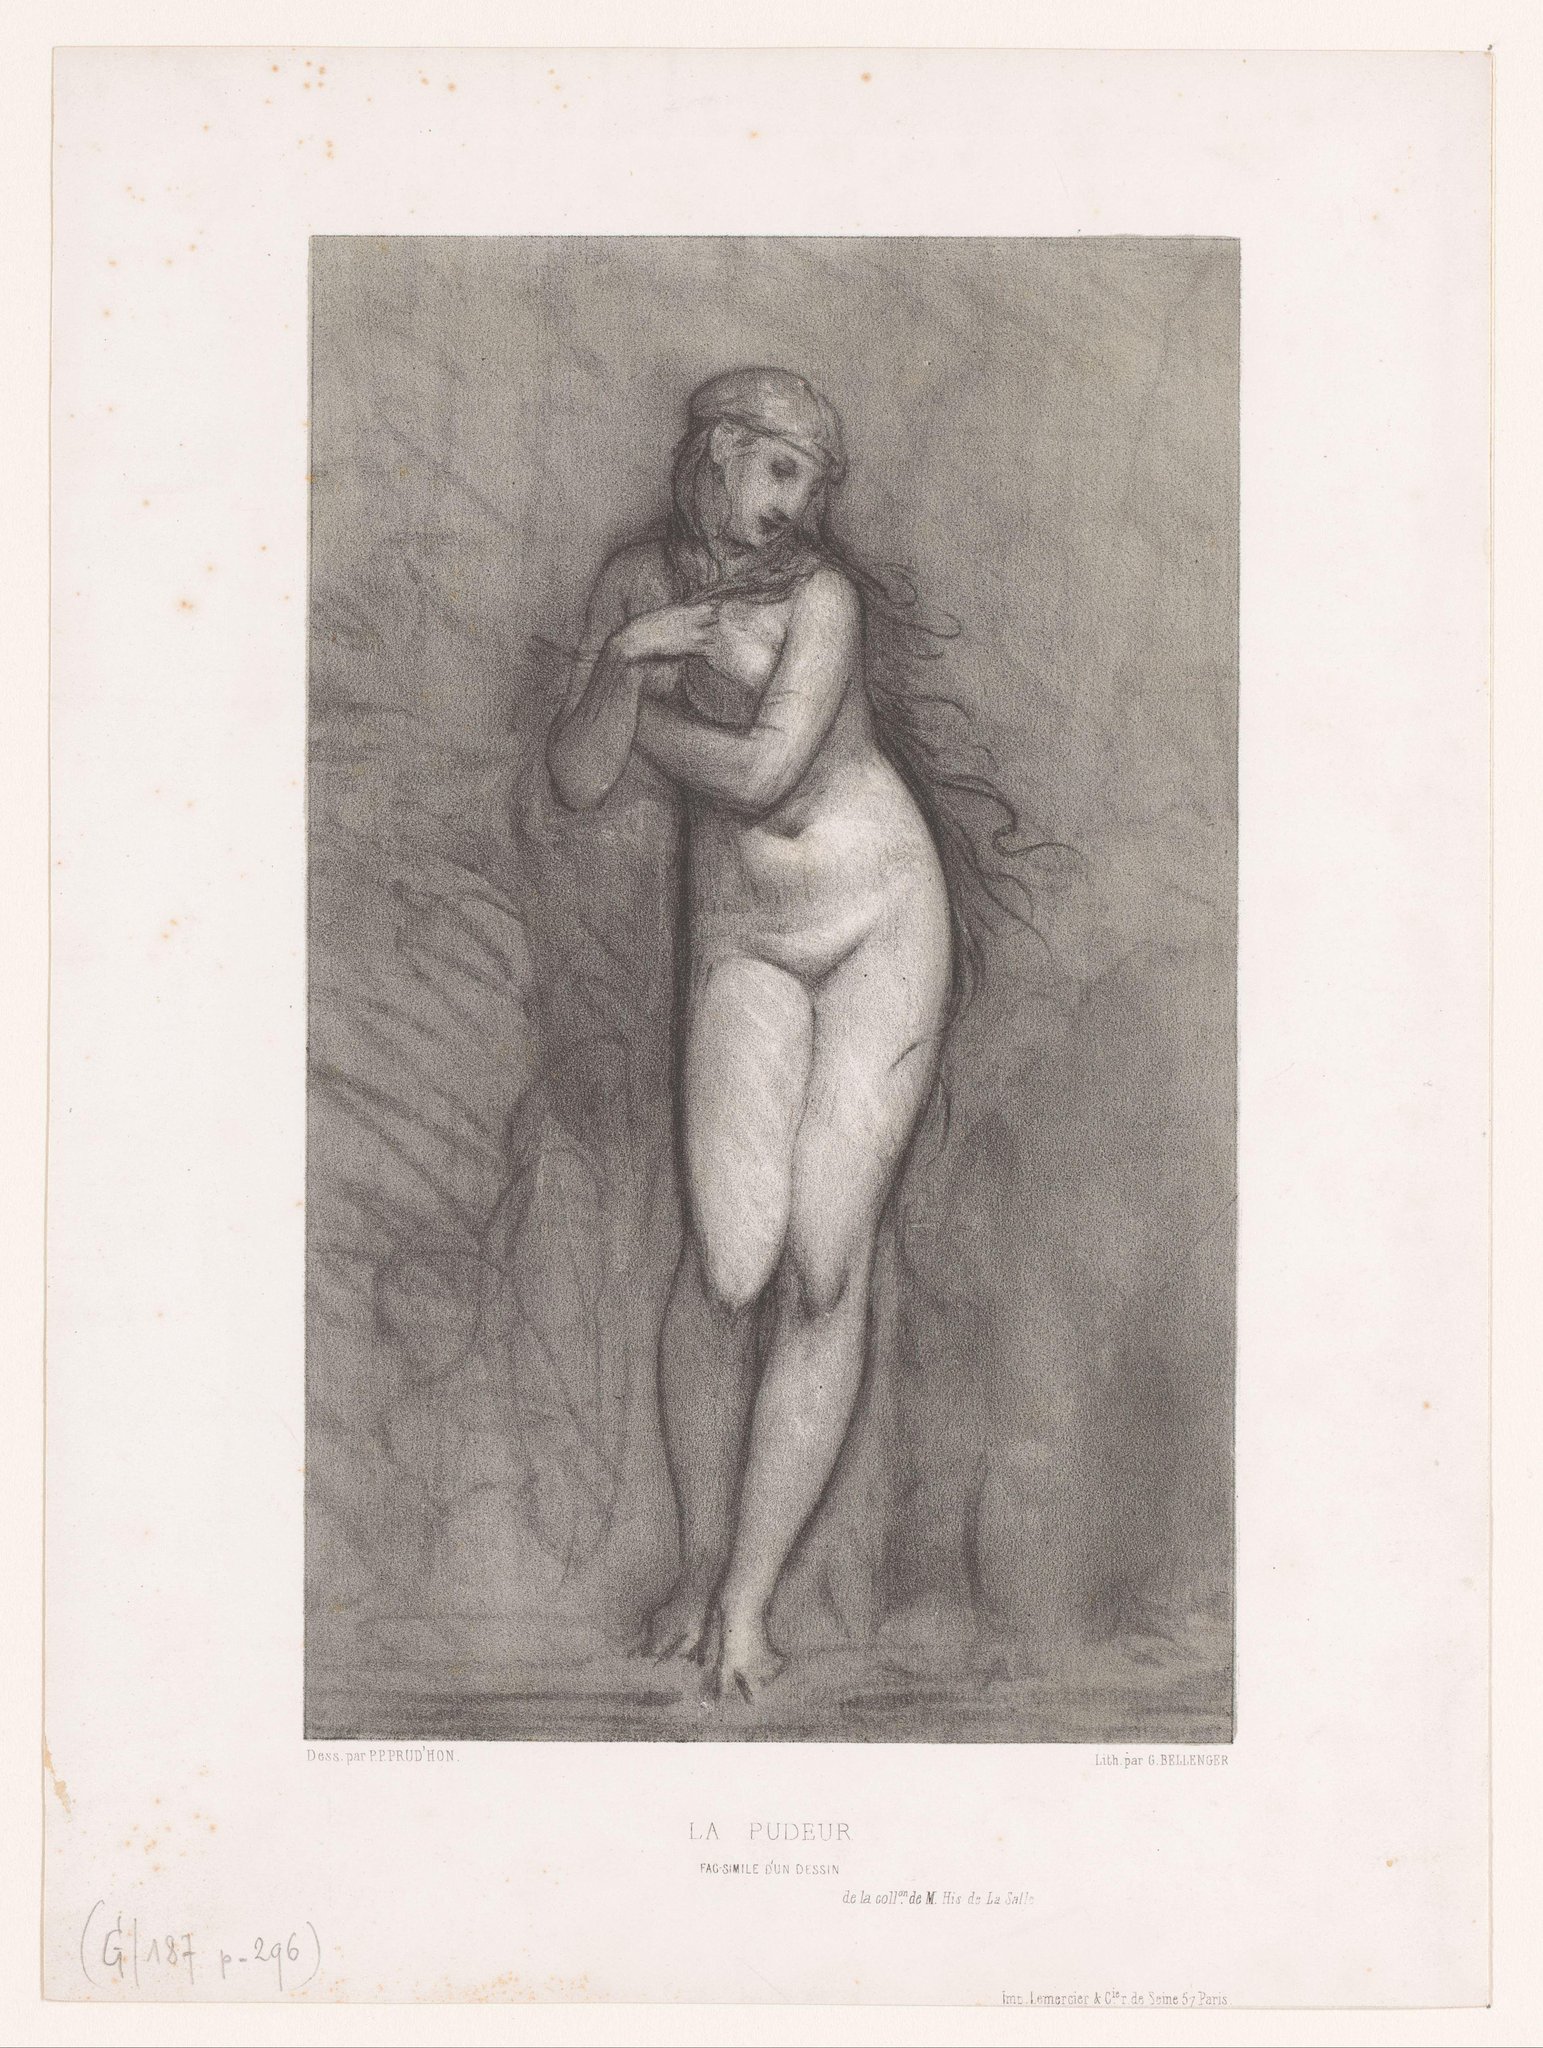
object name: print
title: La pudeur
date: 1857-1915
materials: paper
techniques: tone lithography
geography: paris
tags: discretion, modesty; 'discretione', 'modestia' (ripa)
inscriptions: collector's mark: Lugt 2228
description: Naakte vrouw als personificatie van de bescheidenheid.